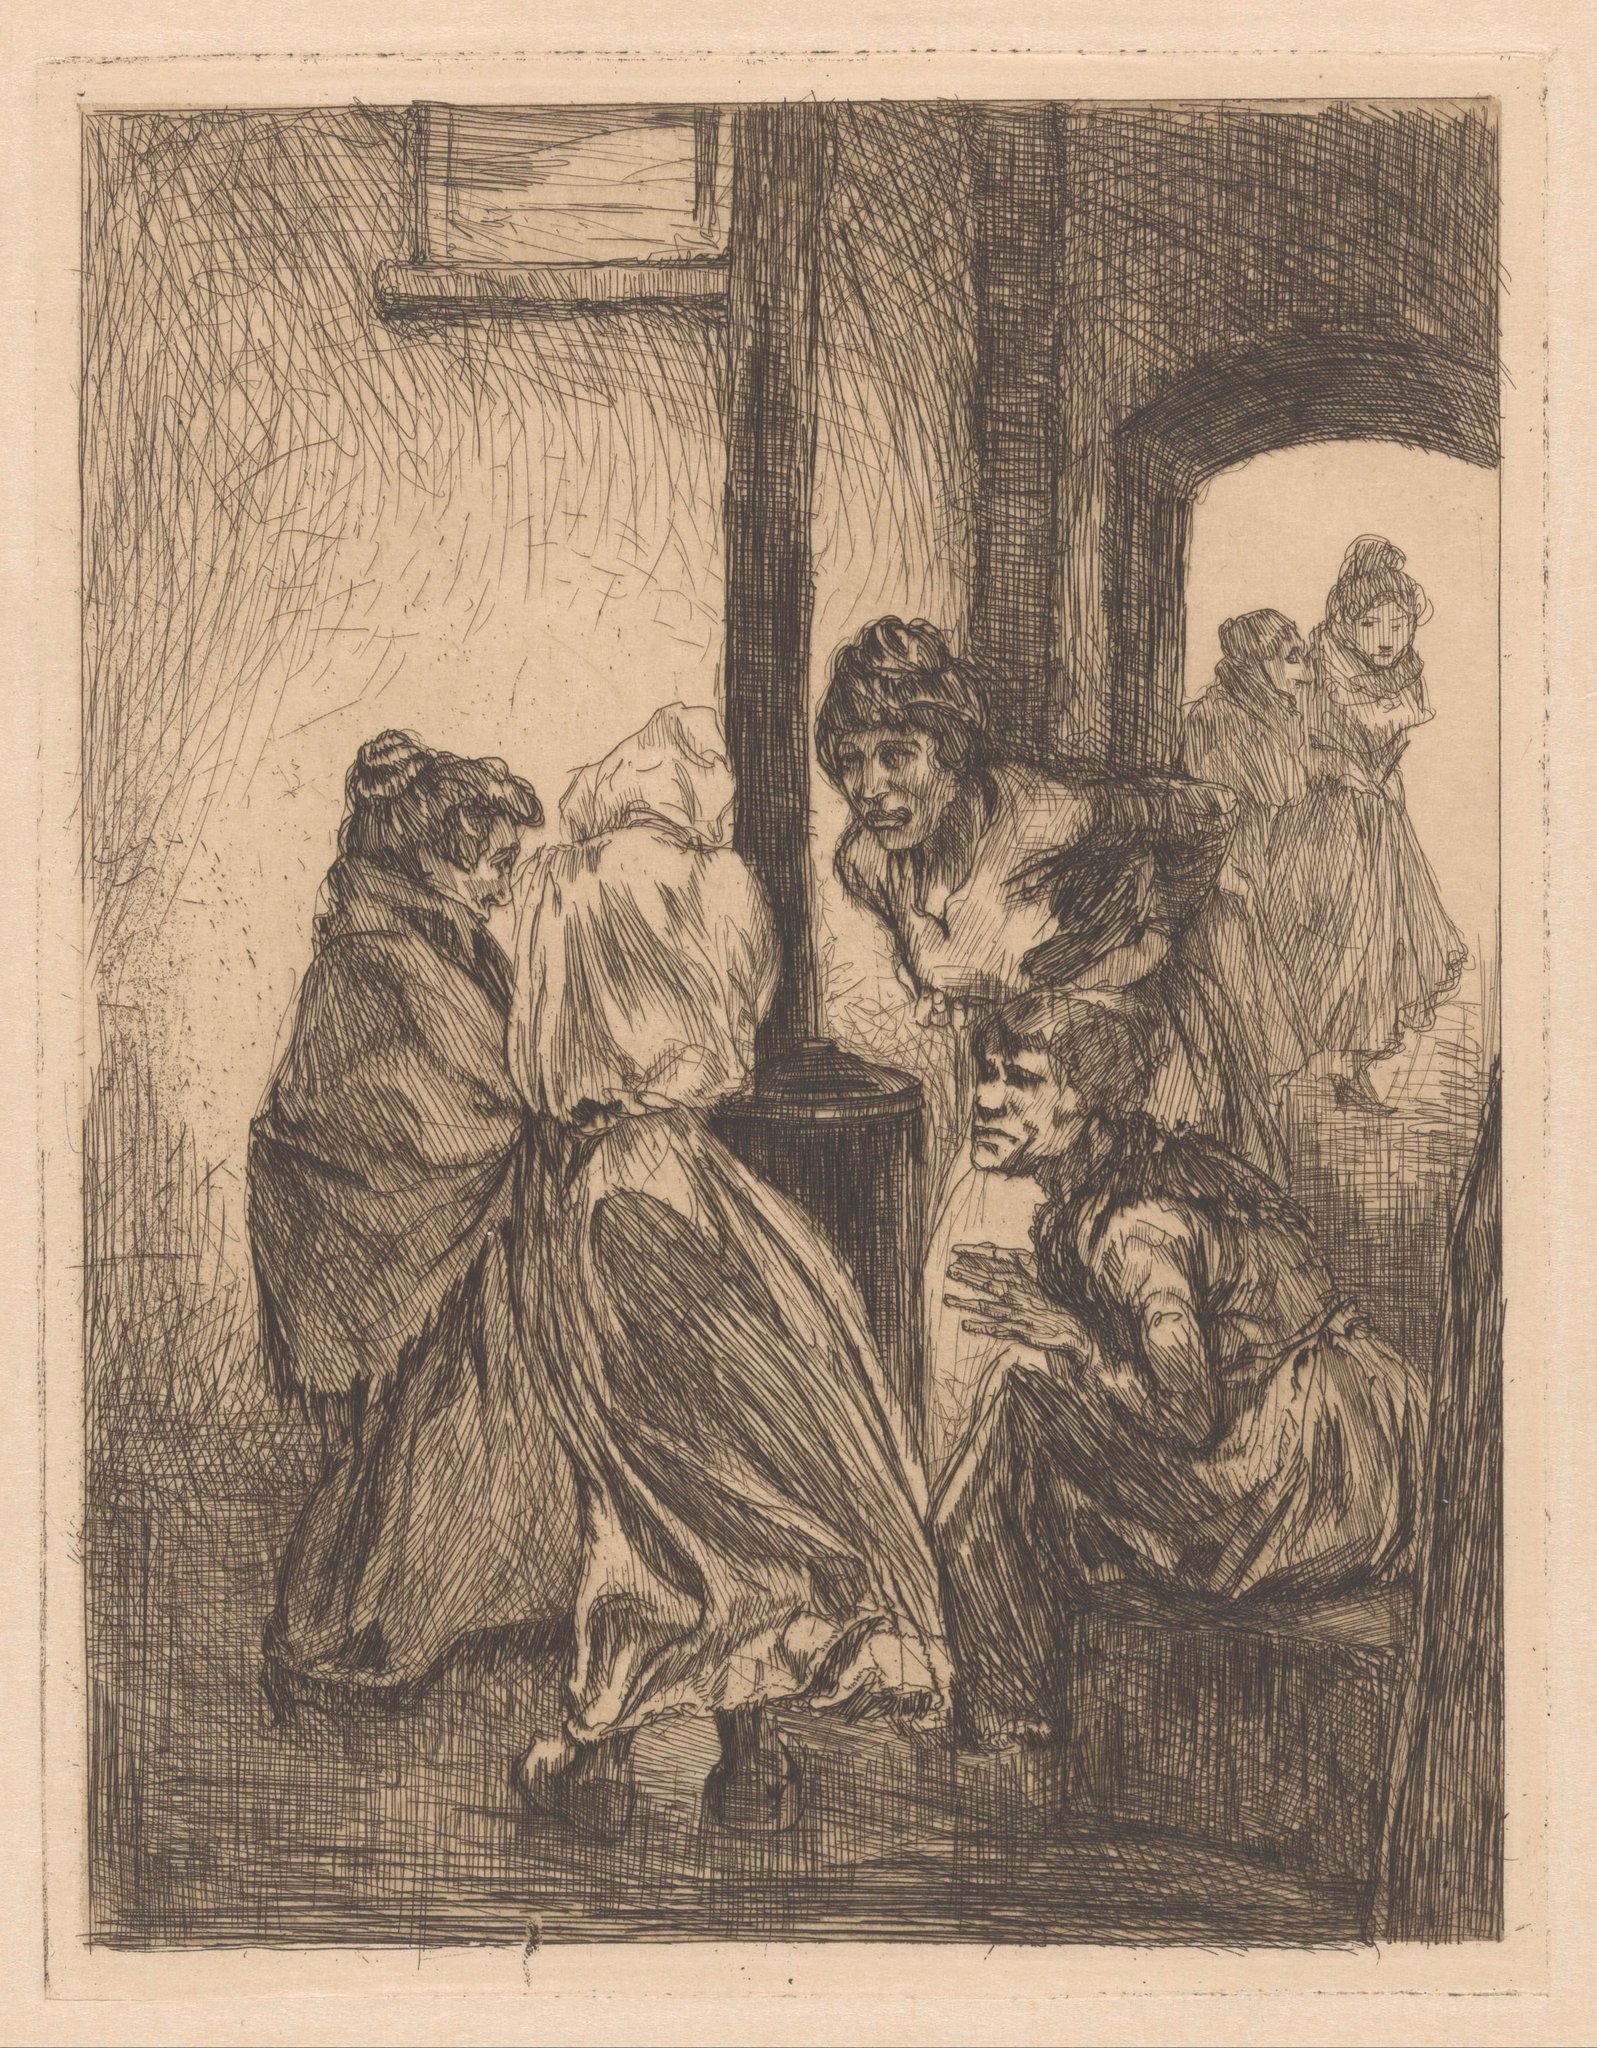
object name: print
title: Vier vrouwen bijeen gedoken om een kachel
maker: johannes josephus aarts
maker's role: draughtsman, print maker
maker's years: 1871-1934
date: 1881-1934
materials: paper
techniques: etching, intaglio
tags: heating stove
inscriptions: collector's mark: Lugt 2228, collector's mark: Lugt 2760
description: Vier vrouwen bukken naar een kachel toe om zich te warmen. Rechts achter hen zijn door een poort twee wandelende vrouwen zichtbaar.